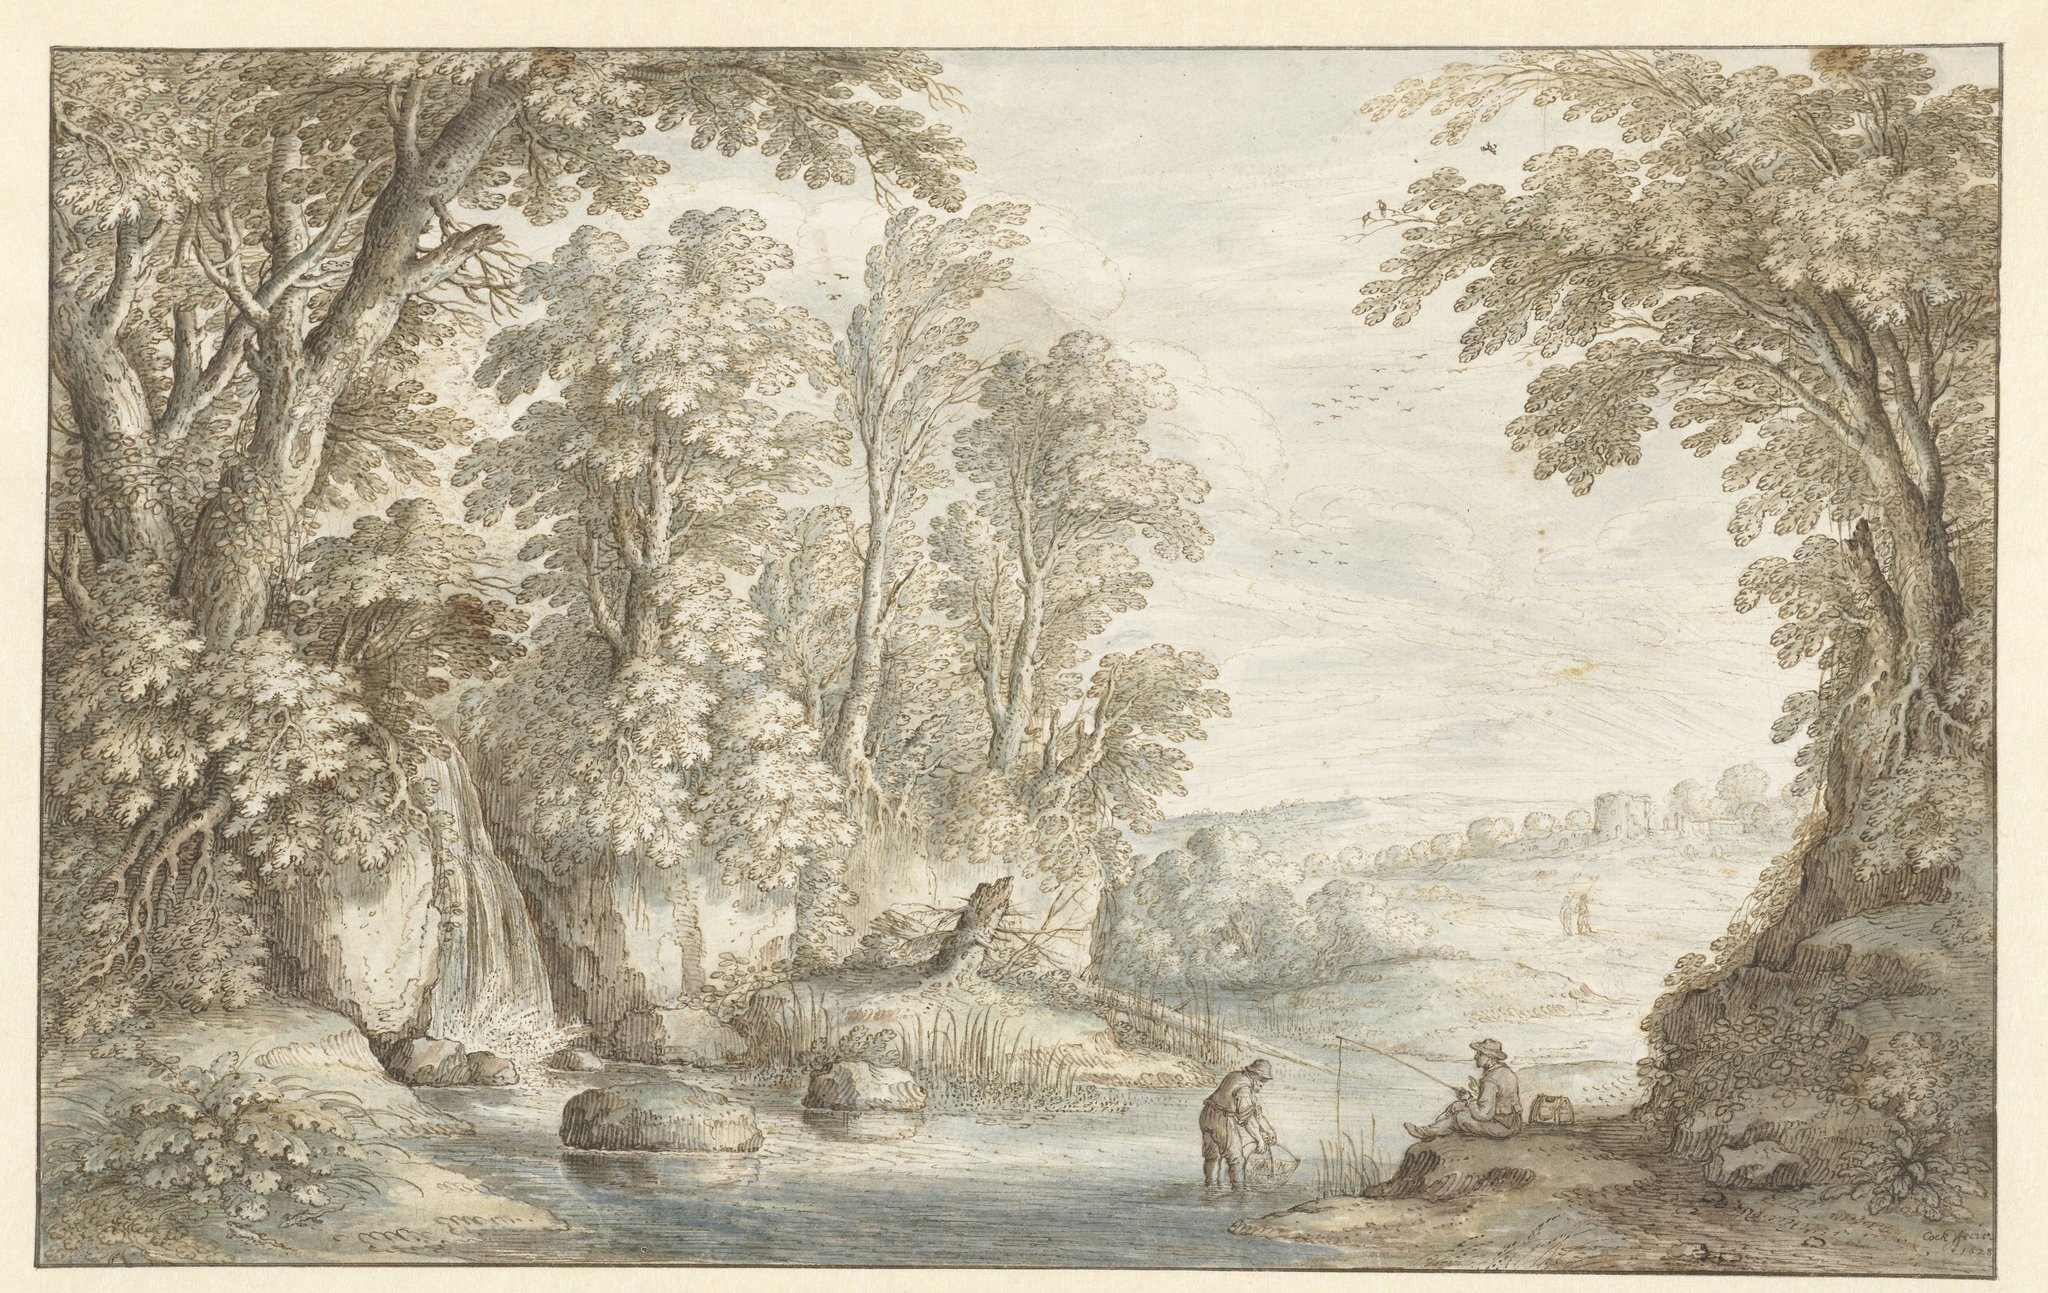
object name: drawing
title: Two Anglers in a Wooded Landscape with a Waterfall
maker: marten de cock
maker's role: draughtsman, print maker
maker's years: 1578-1661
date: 1628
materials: ink, paper, watercolor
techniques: brush, pen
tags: waterfall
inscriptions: date: ‘1628’